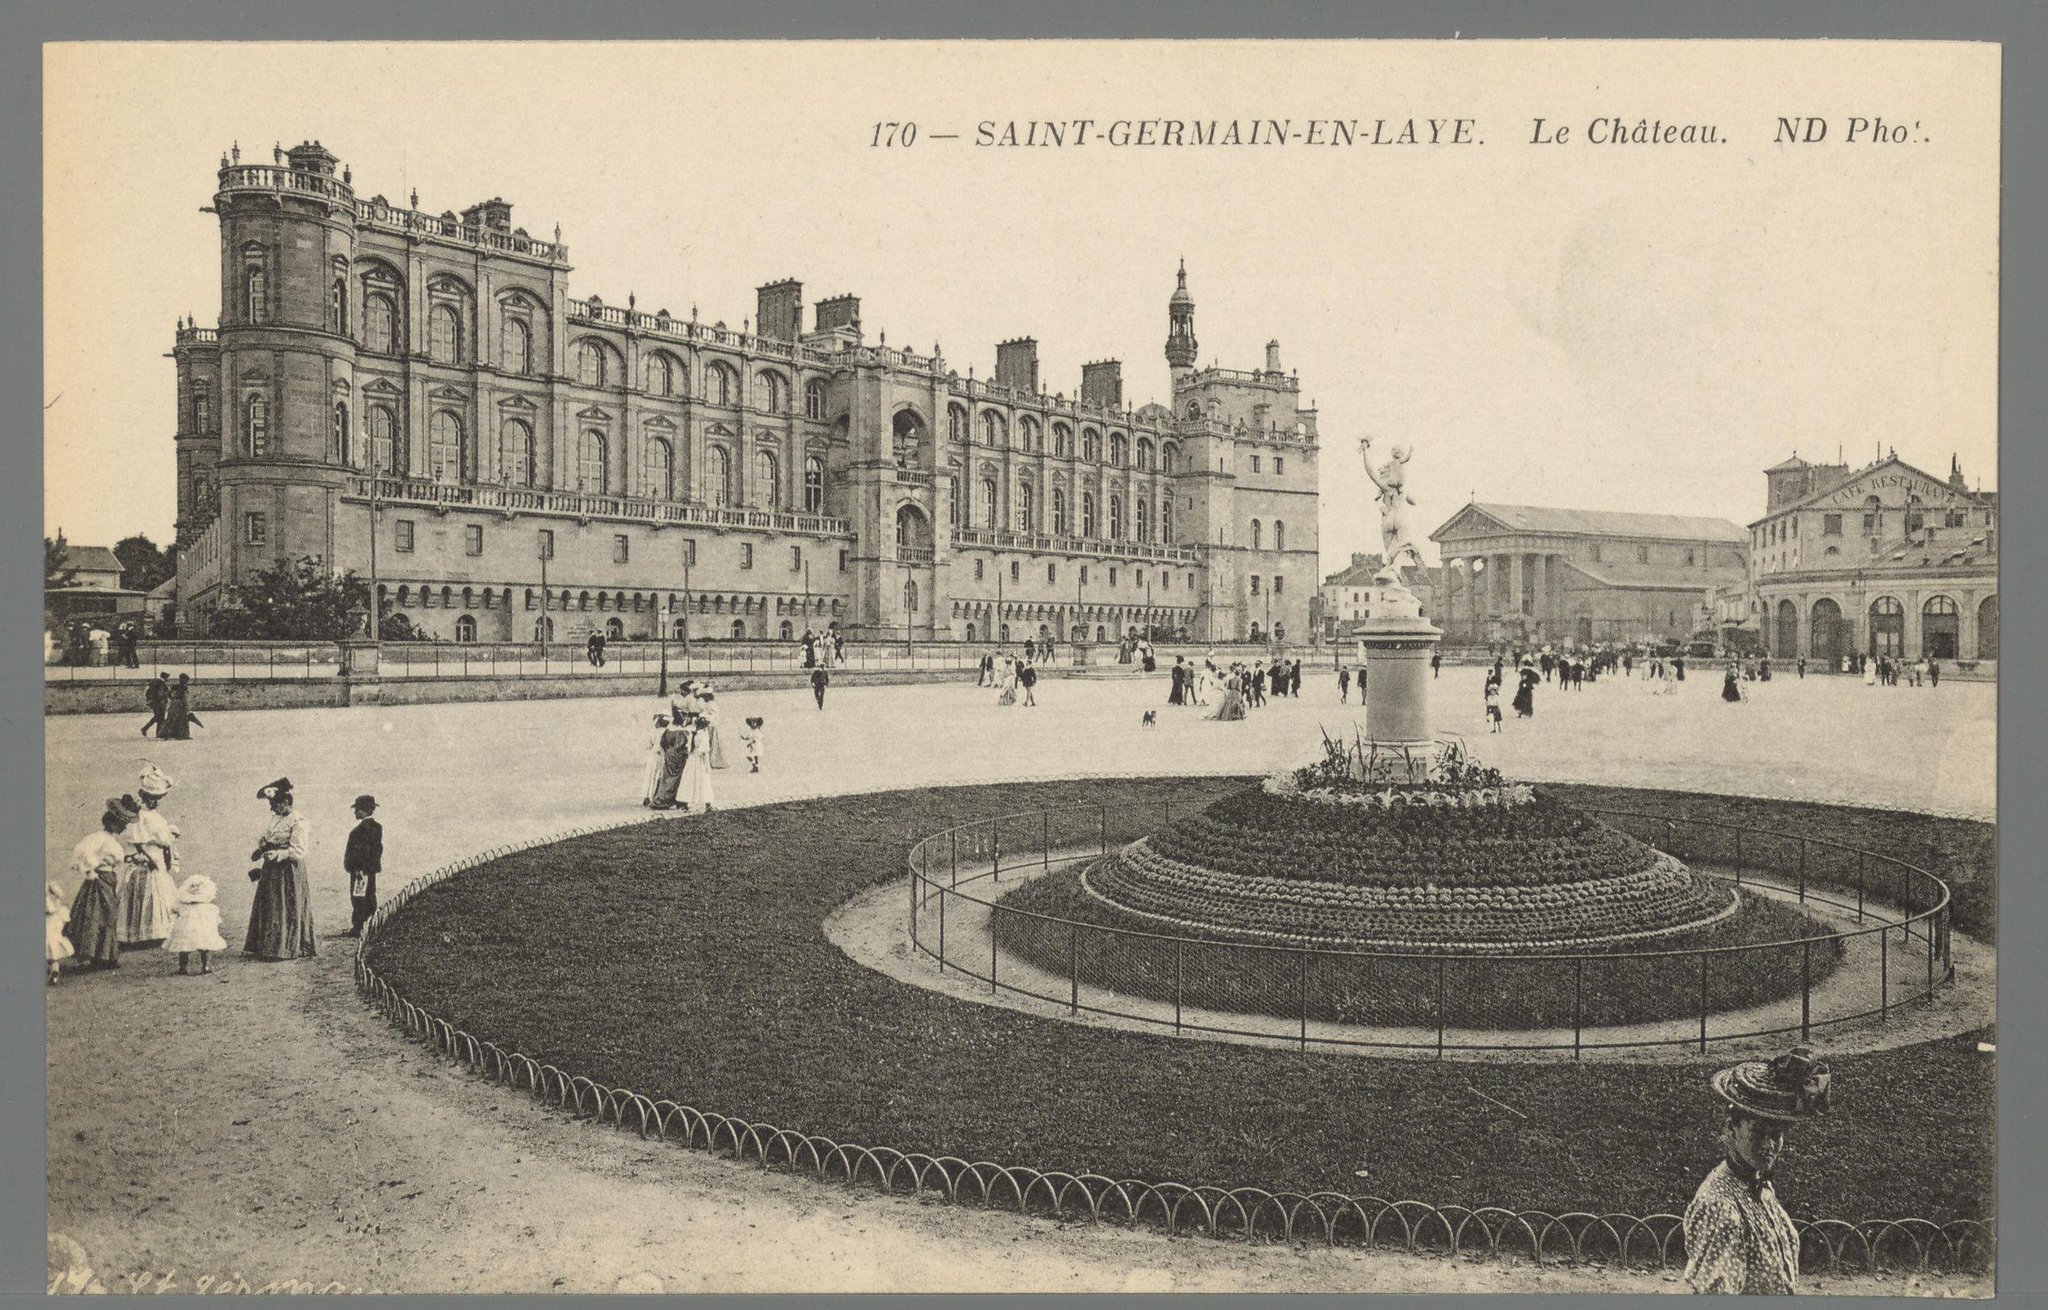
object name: ansichtkaart, prentbriefkaart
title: Saint-Germain-en-Laye. Le Château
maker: Anonymous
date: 1903-1918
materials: cardboard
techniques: photograph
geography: saint-germain-en-laye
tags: public gardens, park (+ city(-scape) with figures, staffage), castle